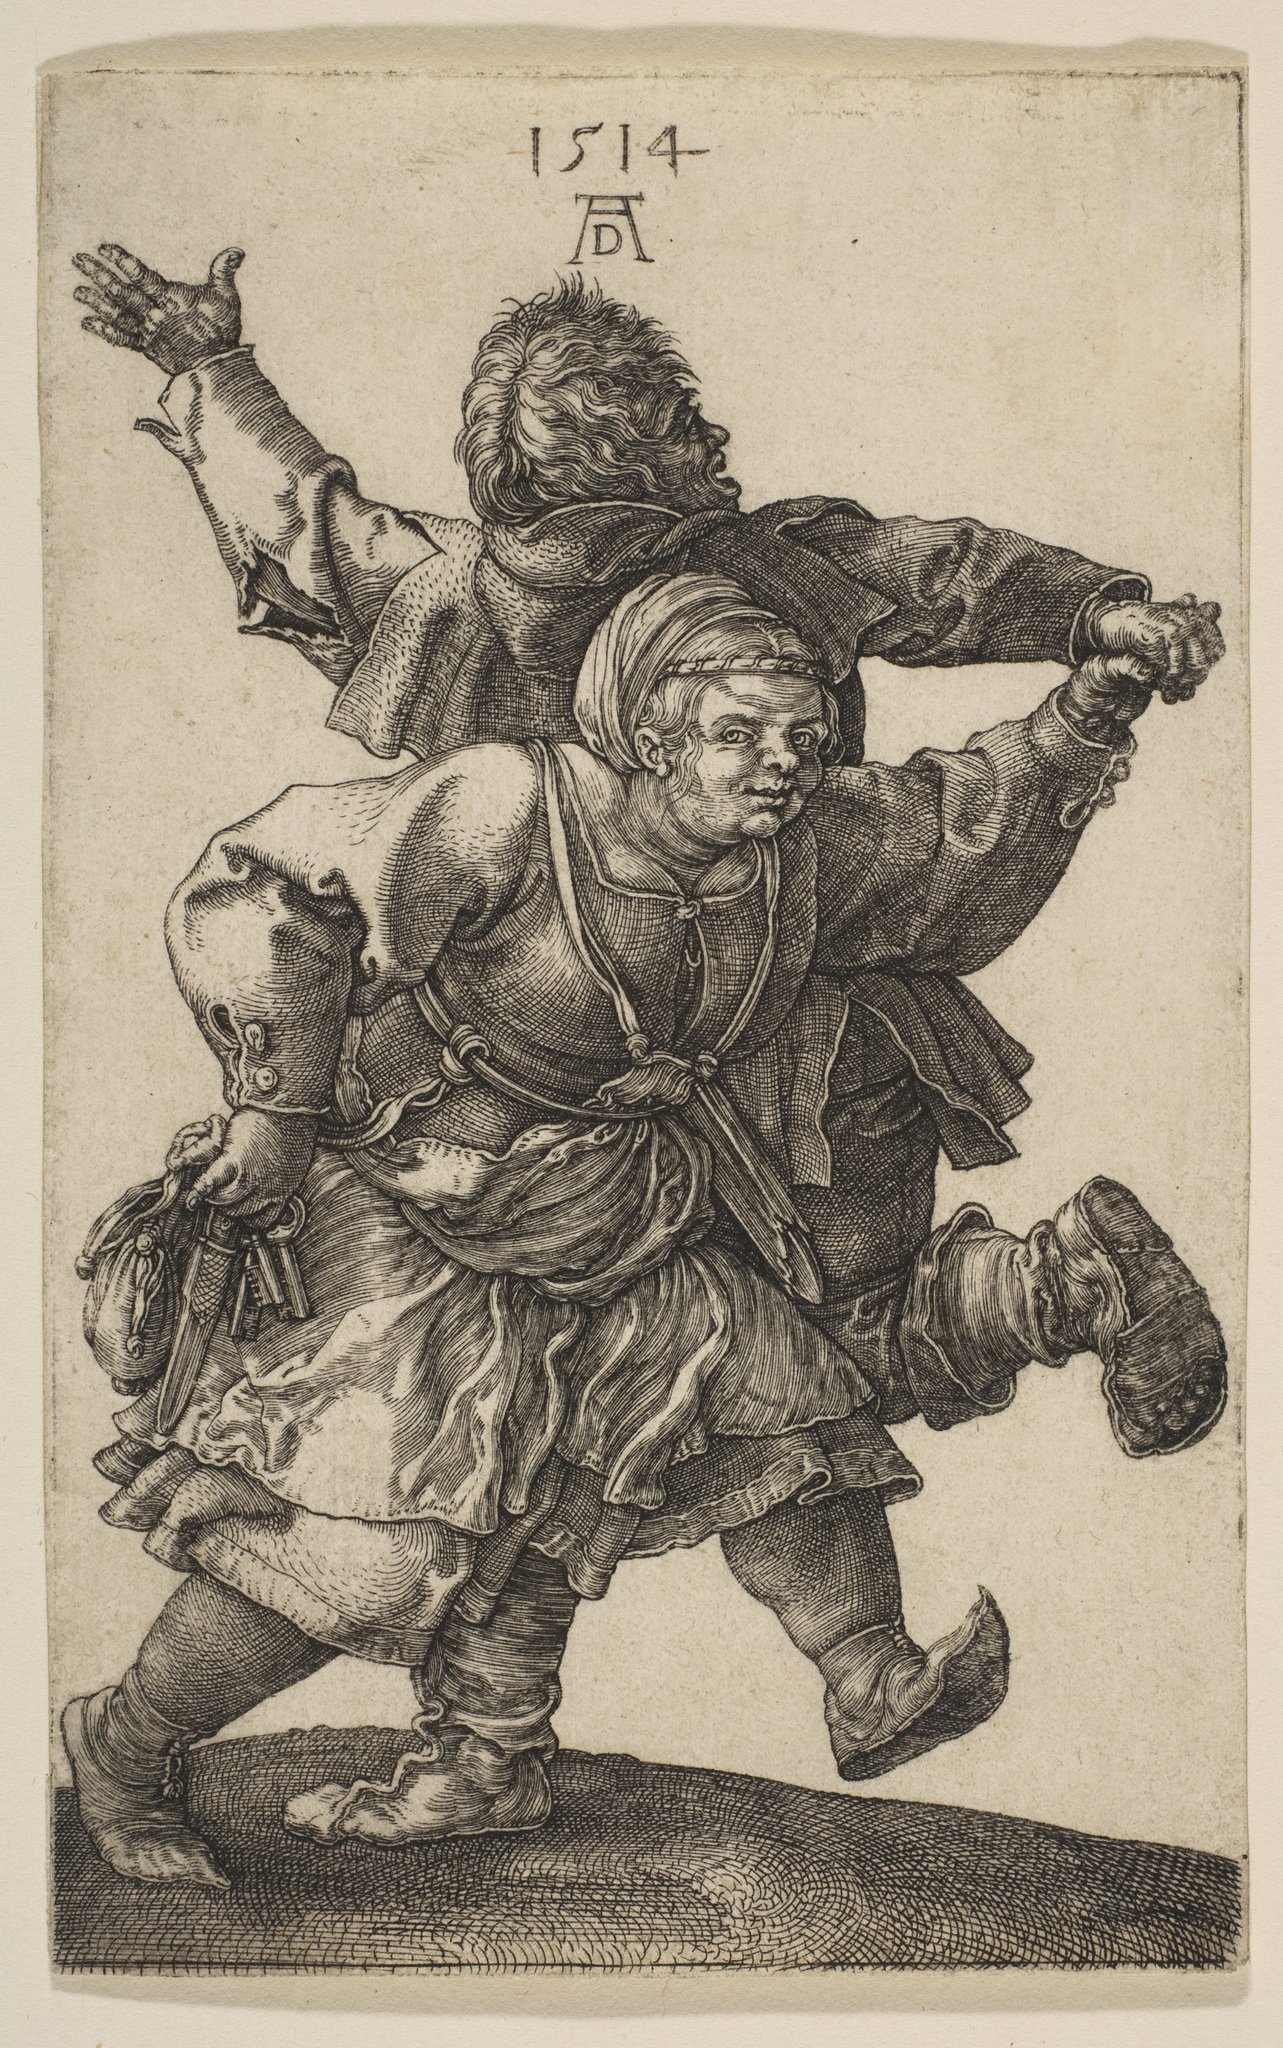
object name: print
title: Peasant Couple Dancing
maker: albrecht dürer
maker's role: artist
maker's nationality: german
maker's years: 1471-1528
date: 1514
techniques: engraving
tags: couples,men,women,dancing,farmers